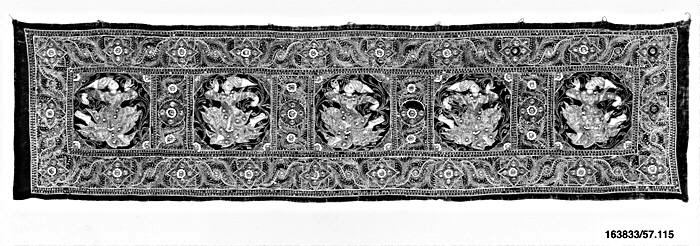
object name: hanging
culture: burmese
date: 1701-1800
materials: metal thread, pearl, silk, stone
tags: human figures